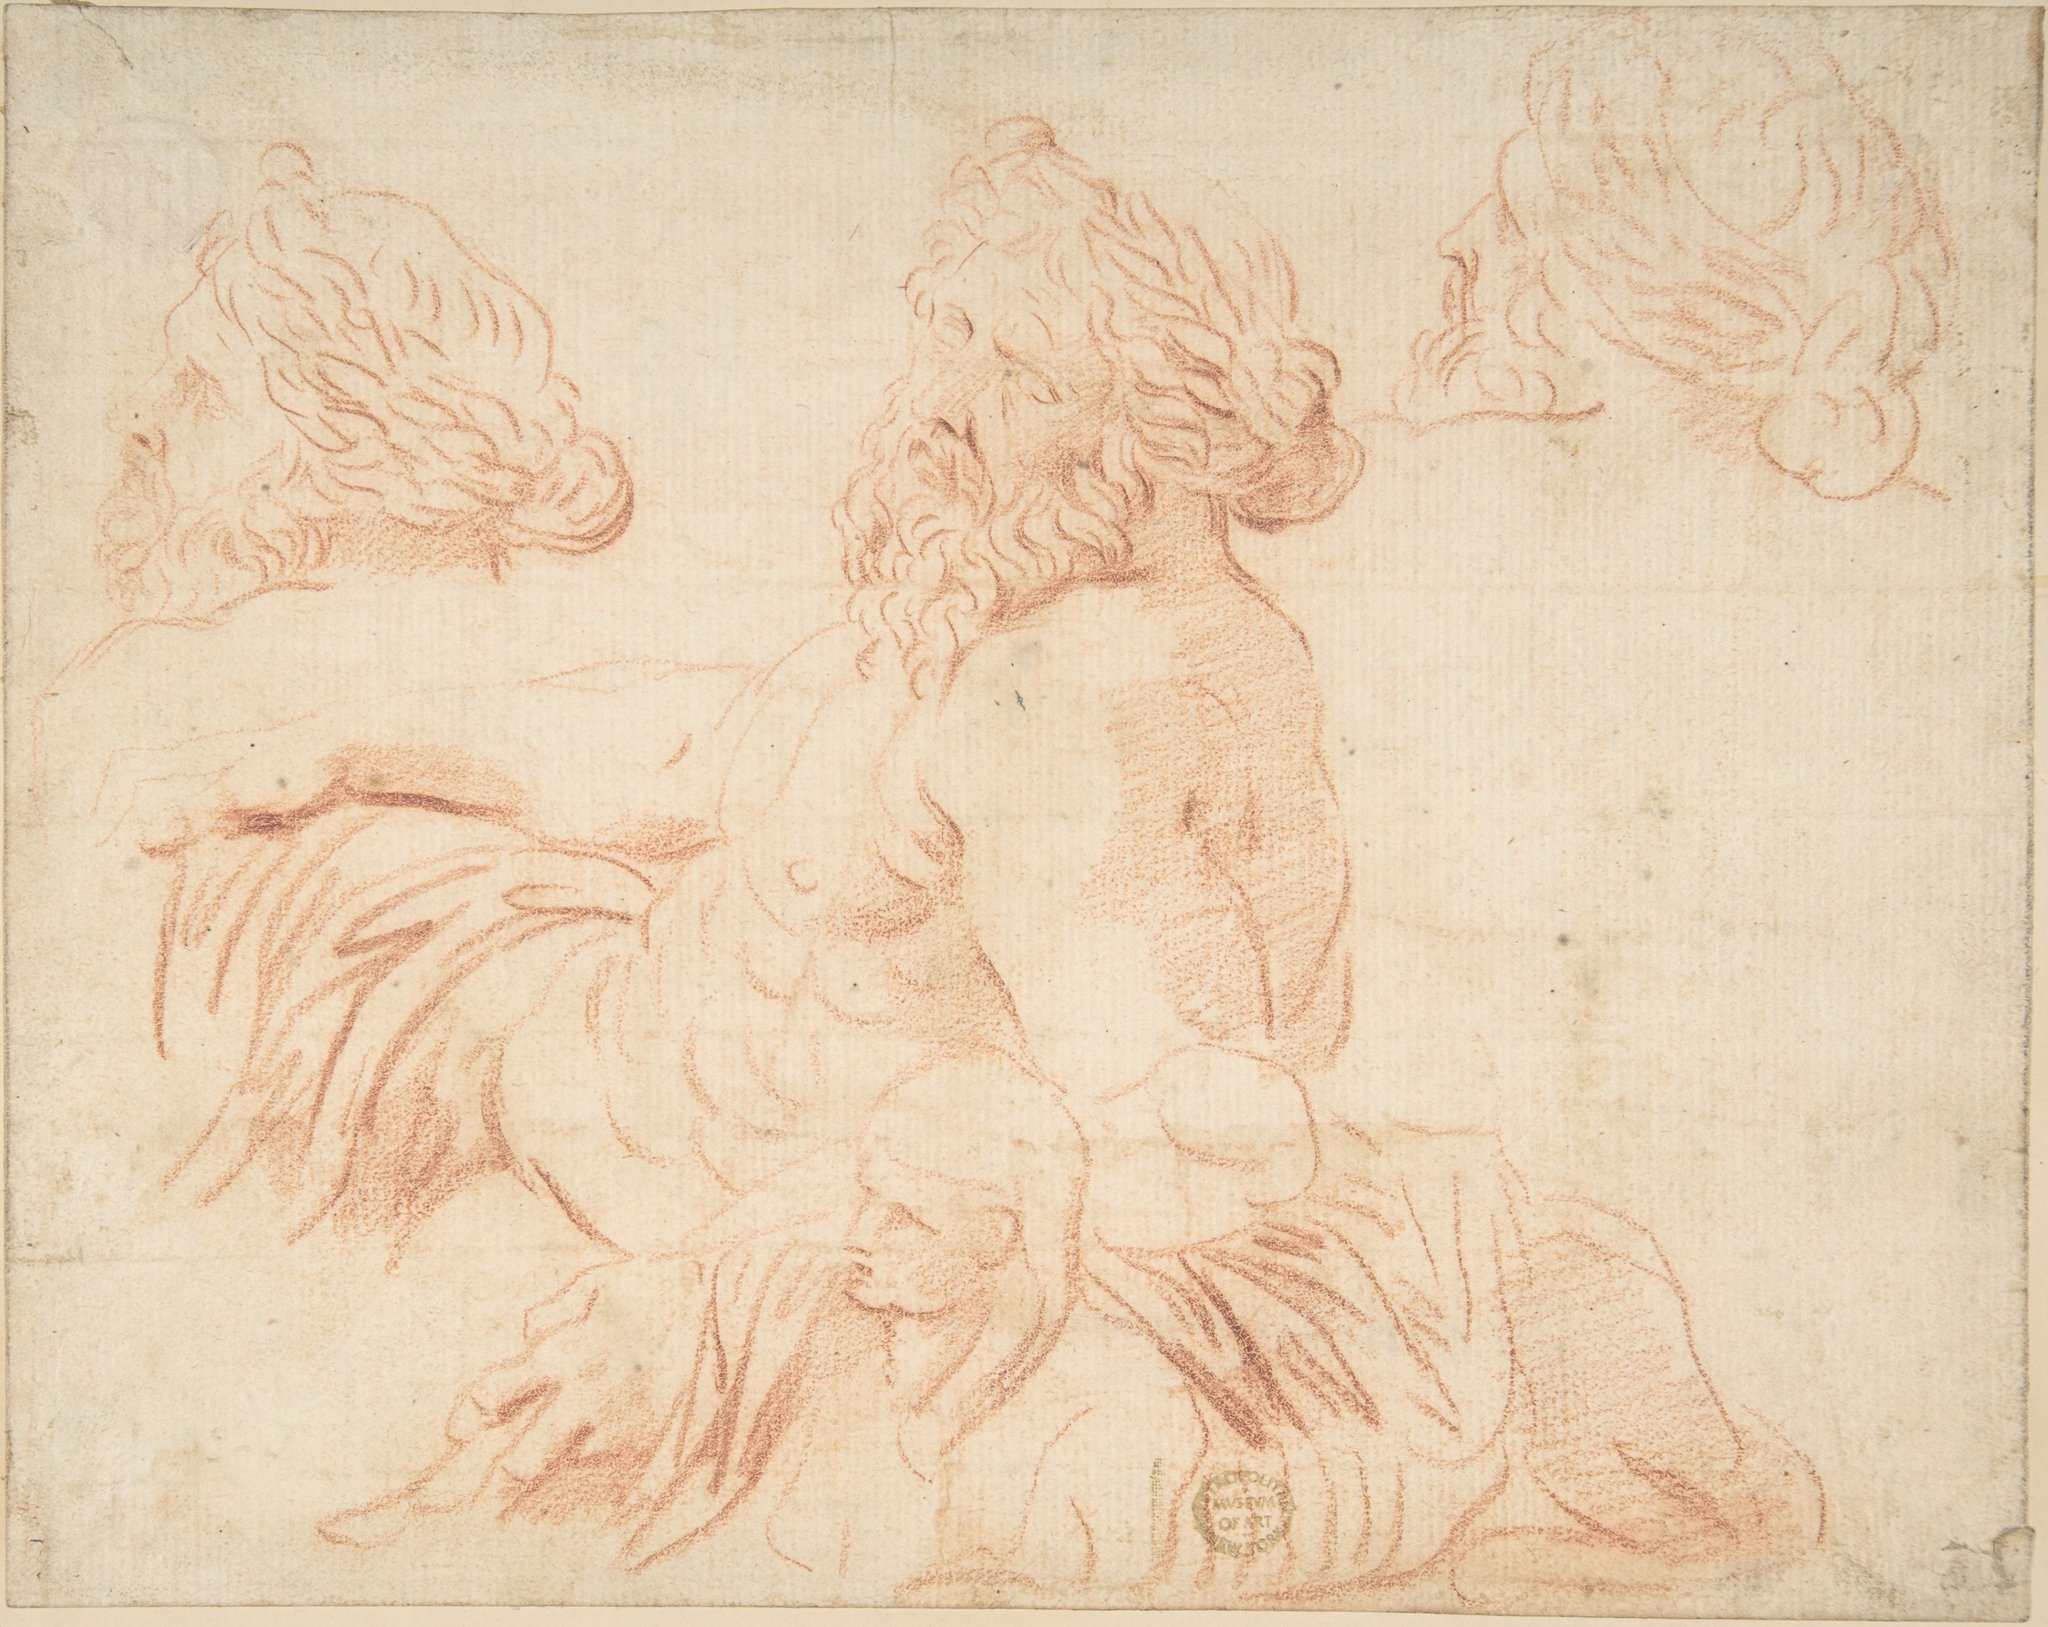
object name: drawing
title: Study from a Statue of a River God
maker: anonymous, italian, roman-bolognese, 17th century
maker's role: artist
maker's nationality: italian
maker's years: 1600-1700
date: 1601-1700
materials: chalk, paper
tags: gods